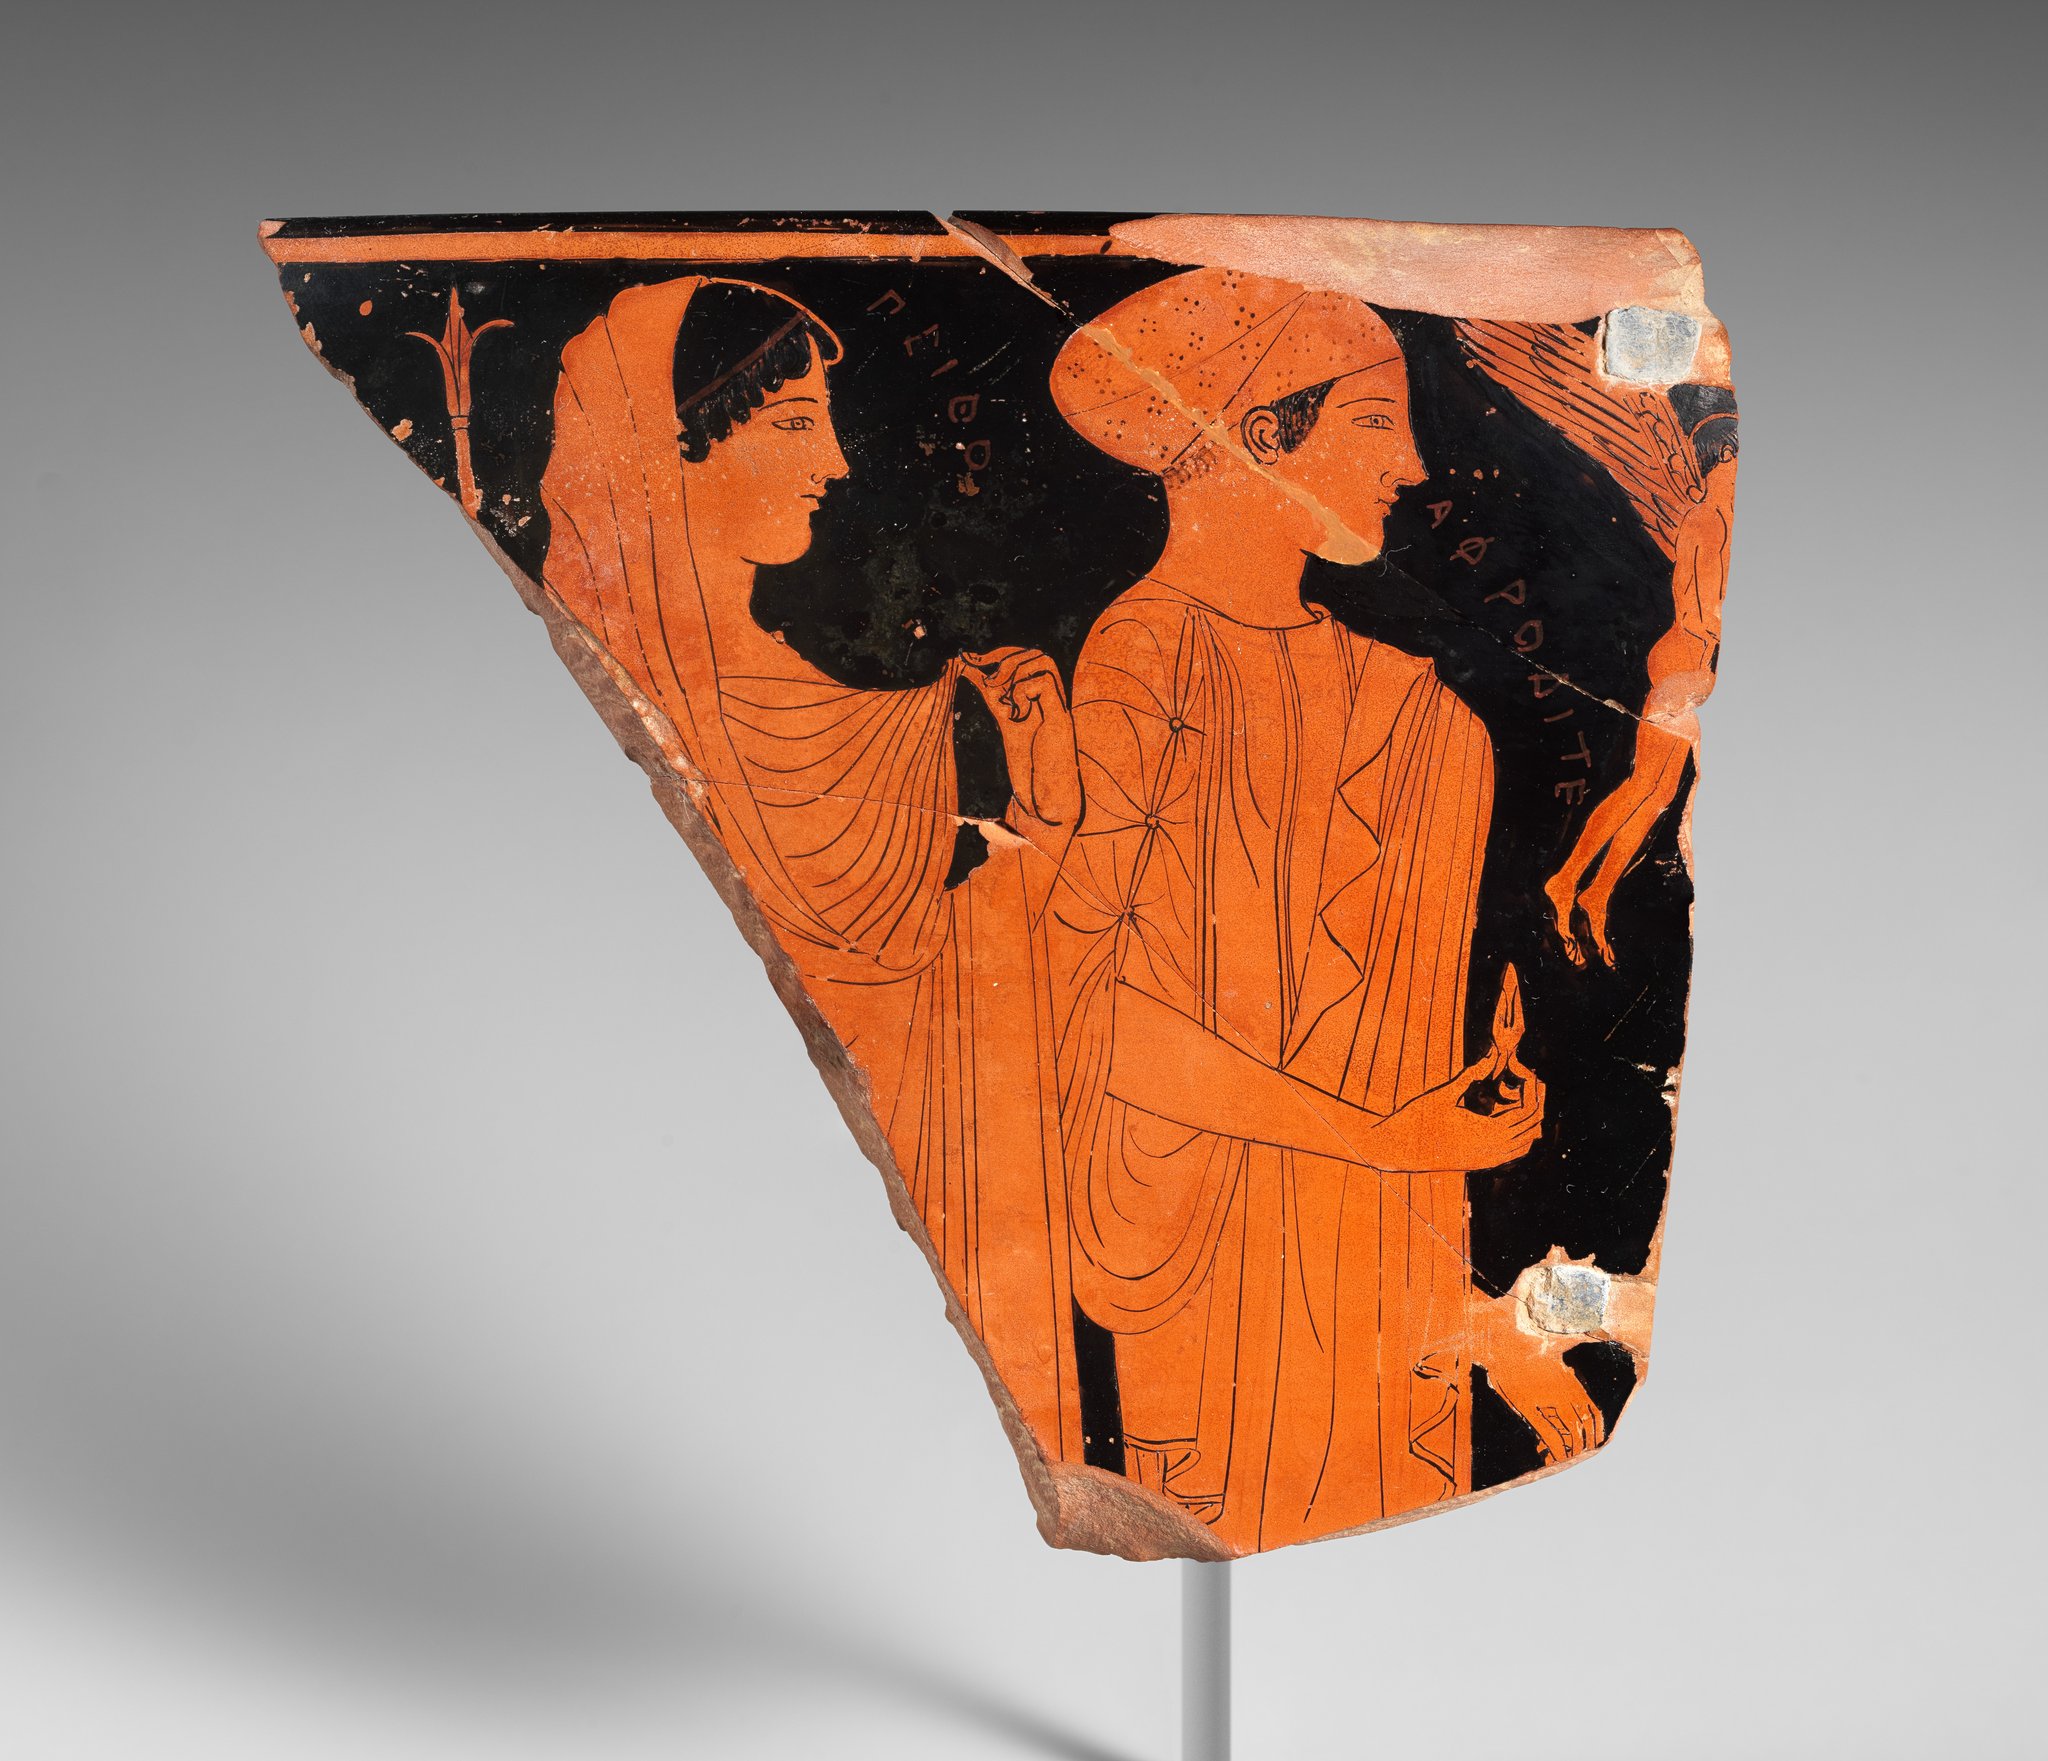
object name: skyphos, fragmentary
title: Fragment of a terracotta skyphos (deep drinking cup)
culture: greek, attic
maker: douris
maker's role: artist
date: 490 BCE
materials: terracotta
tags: men,women